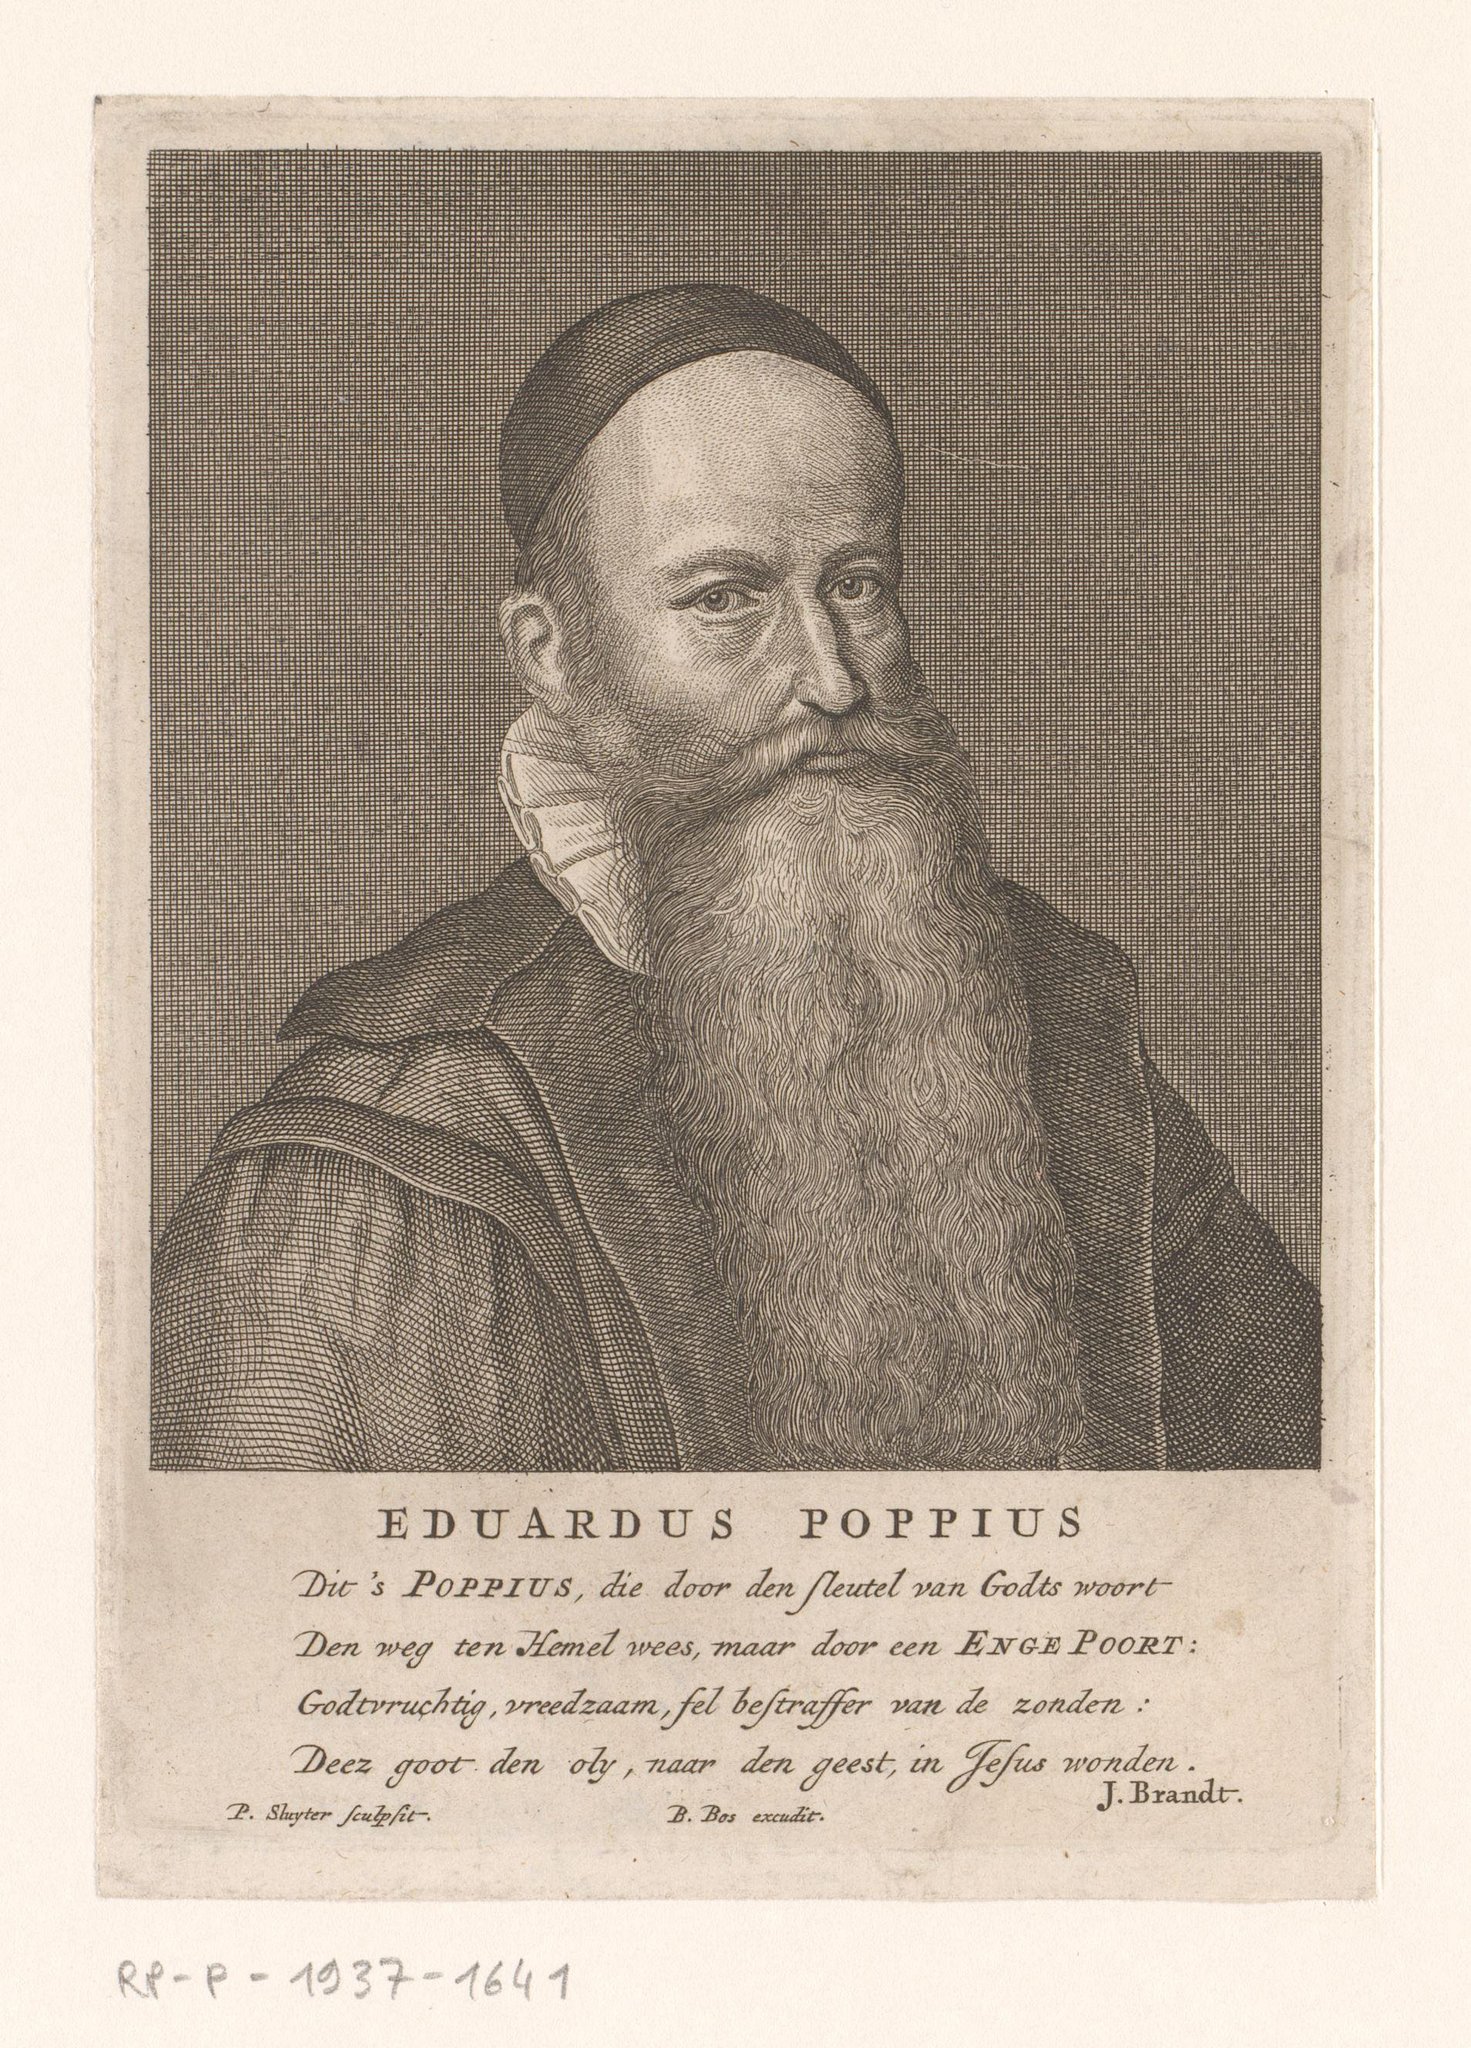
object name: print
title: Portret van Eduard Poppius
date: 1704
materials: paper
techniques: engraving, etching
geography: amsterdam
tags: historical persons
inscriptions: inscription: ‘in Franken aanwezig/ Gm’, collector's mark: Lugt 2760, collector's mark: Lugt 2228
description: Prent waarschijnlijk uit: Brandt, Gerard. Historie der Reformatie, en andre kerkelyke geschiedenissen (...). Rotterdam: Barent Bos, 1704, dl. 4.